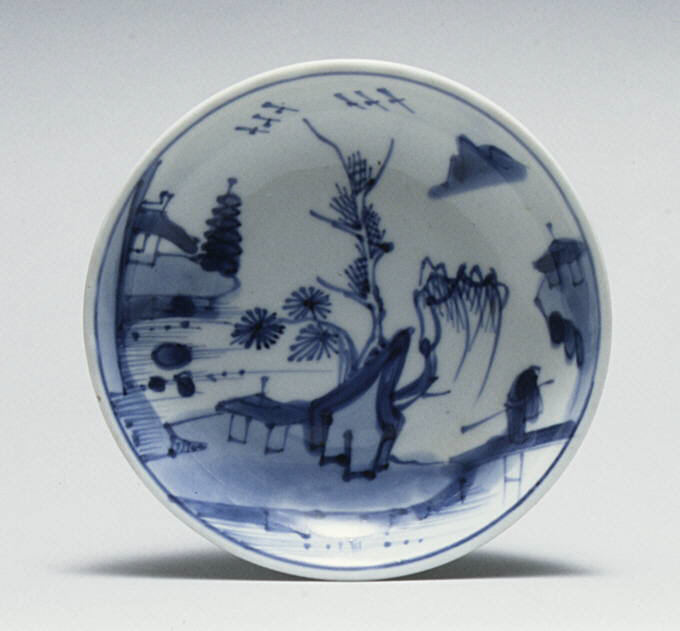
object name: saucer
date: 1700-1720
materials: hard paste porcelain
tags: trees